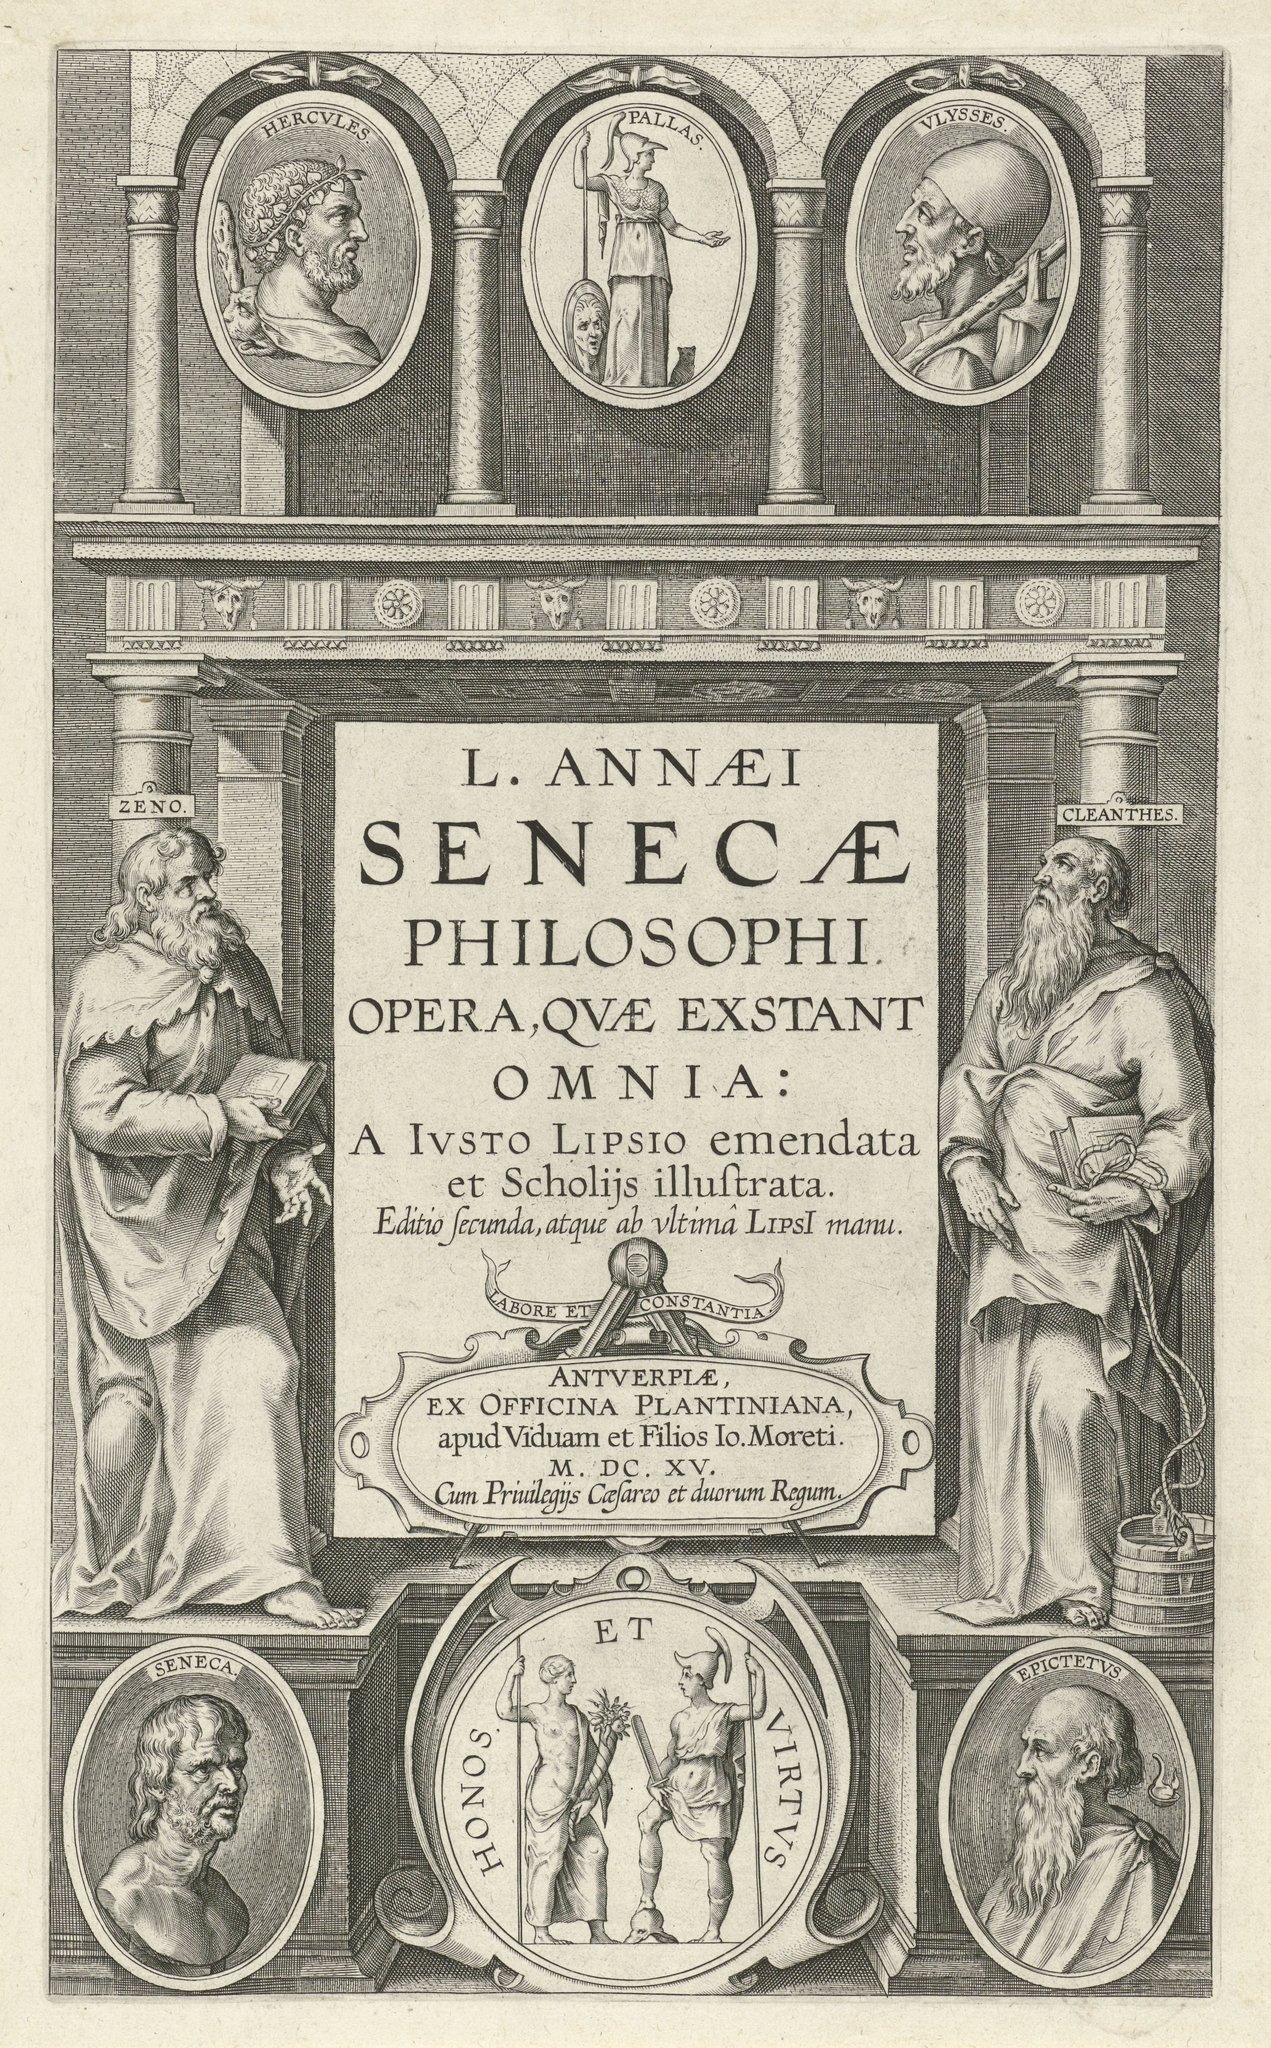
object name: print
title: Titelpagina voor L. Annaei Senecae Philosophi Opera, 1615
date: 1615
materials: paper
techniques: engraving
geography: antwerp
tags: (story of) hercules (heracles), (story of) minerva (pallas, athena), male persons from classical history (zeno), (story of) seneca, (story of) ulysses, male persons from classical history (cleanthes), male persons from classical history (epictetus)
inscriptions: collector's mark: Lugt 240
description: Centraal in een rechthoekig kader de titel van het boekwerk. Aan weerszijden van het kader de klassieke filosofen Zeno en Cleanthes. Bovenaan de prent de portretten van Hercules, Minerva en Odysseus in ovale lijsten. Onderaan de prent de portretten van Seneca en Epictetus.